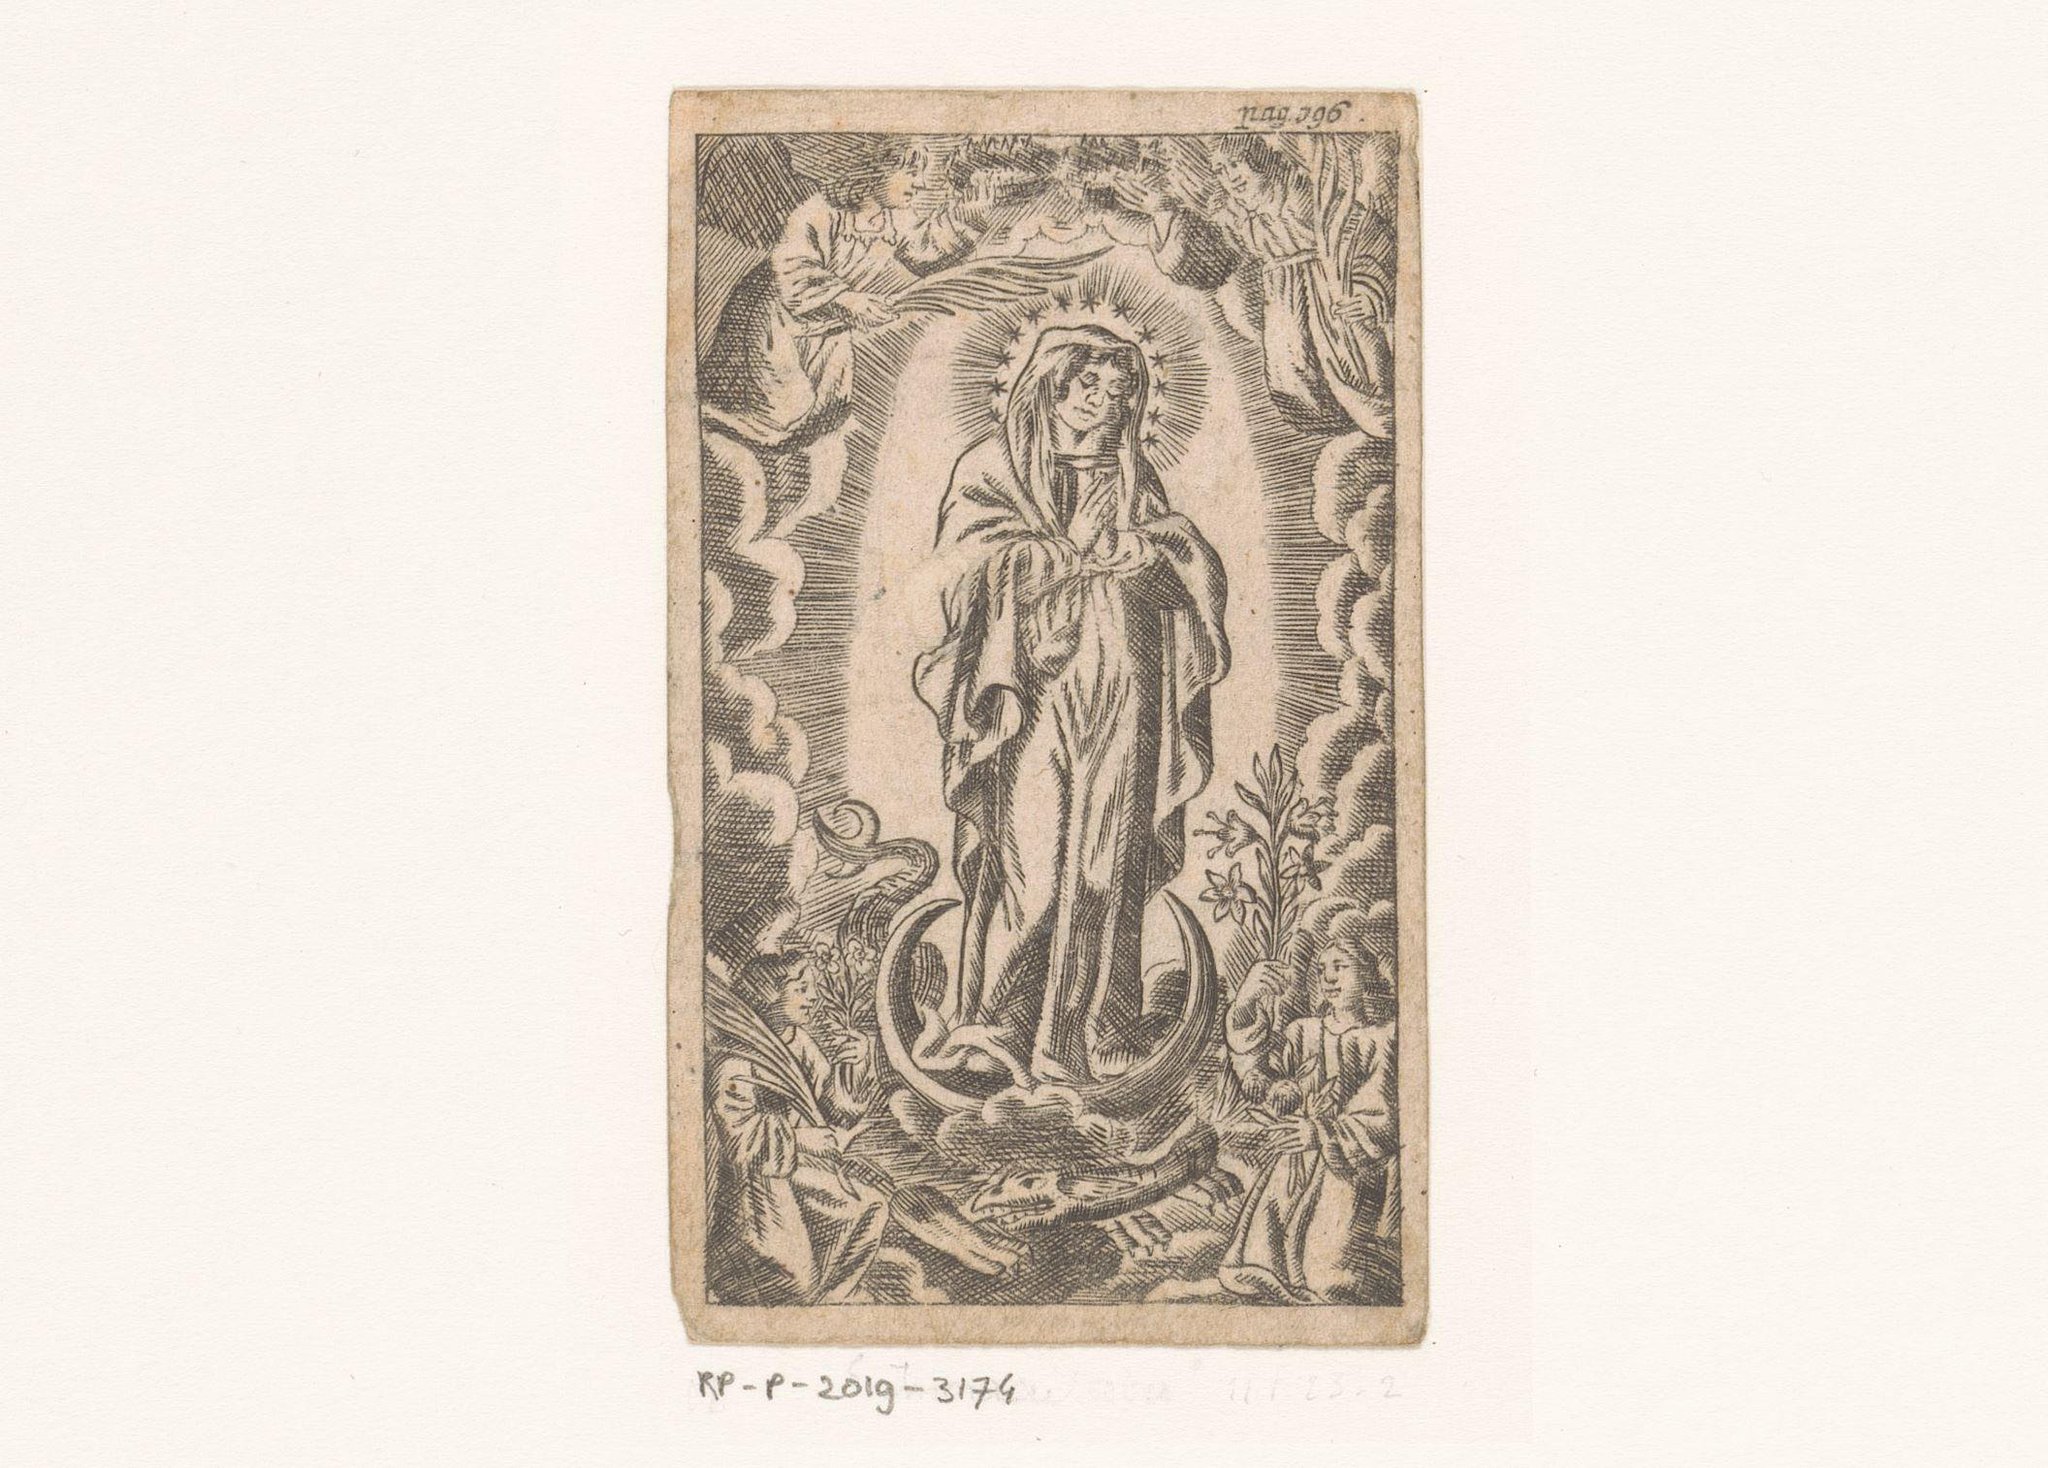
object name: print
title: Onbevlekte Ontvangenis van Maria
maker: Anonymous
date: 1700-1799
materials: paper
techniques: engraving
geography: netherlands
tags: 'immaculata', 'purisima': mary, usually standing on a crescent moon, descending from heaven, exempt from original sin (sometimes trampling serpent)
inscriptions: collector's mark: Lugt 2228